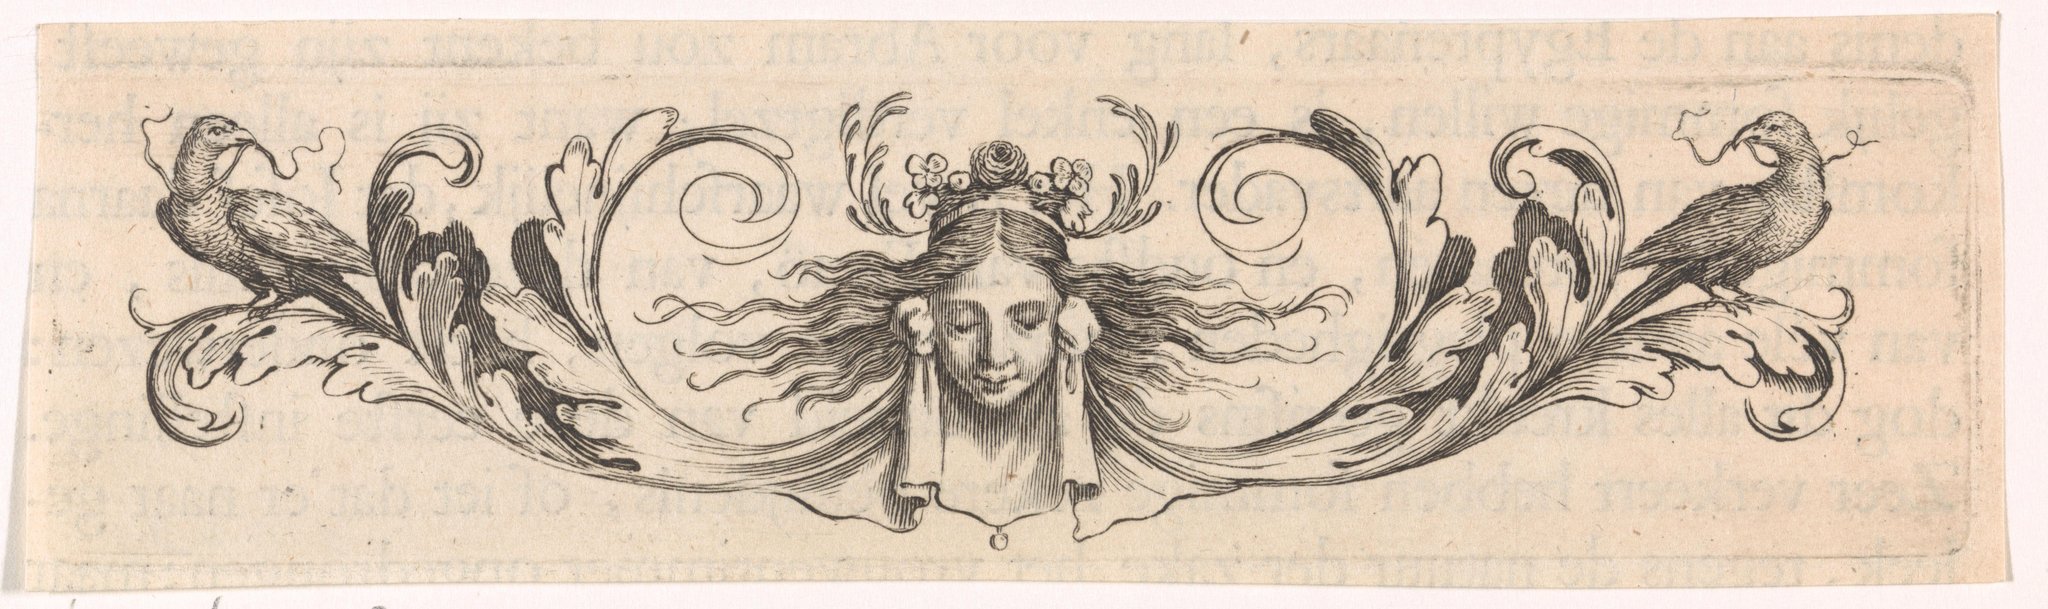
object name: book illustration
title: Vignet met een mascaron, twee vogels en bladranken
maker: bernard picart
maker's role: draughtsman, print maker, publisher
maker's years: 1673-1733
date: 1683-1733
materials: paper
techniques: engraving, etching, letterpress printing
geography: amsterdam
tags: ornament derived from animal forms, mask, mascaron ~ ornament, foliage, tendrils, branches ~ ornament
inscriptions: collector's mark: Lugt 2228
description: Prent oorspronkelijk bedoeld voor: Figures de la Bible. Amsterdam, Bernard Picart, 1720. Prent ook gebruikt in: Taferelen der voornaamste geschiedenissen van het Oude en Nieuwe Testament (...) door de vermaarde kunstenaars Hoet, Houbraken, en Picart getekent (...) en met beschrijvingen uitgebreid. Den Haag: Pieter de Hondt, 1728. Prent kan mogelijk ook zijn gebruikt in andere bijbels.